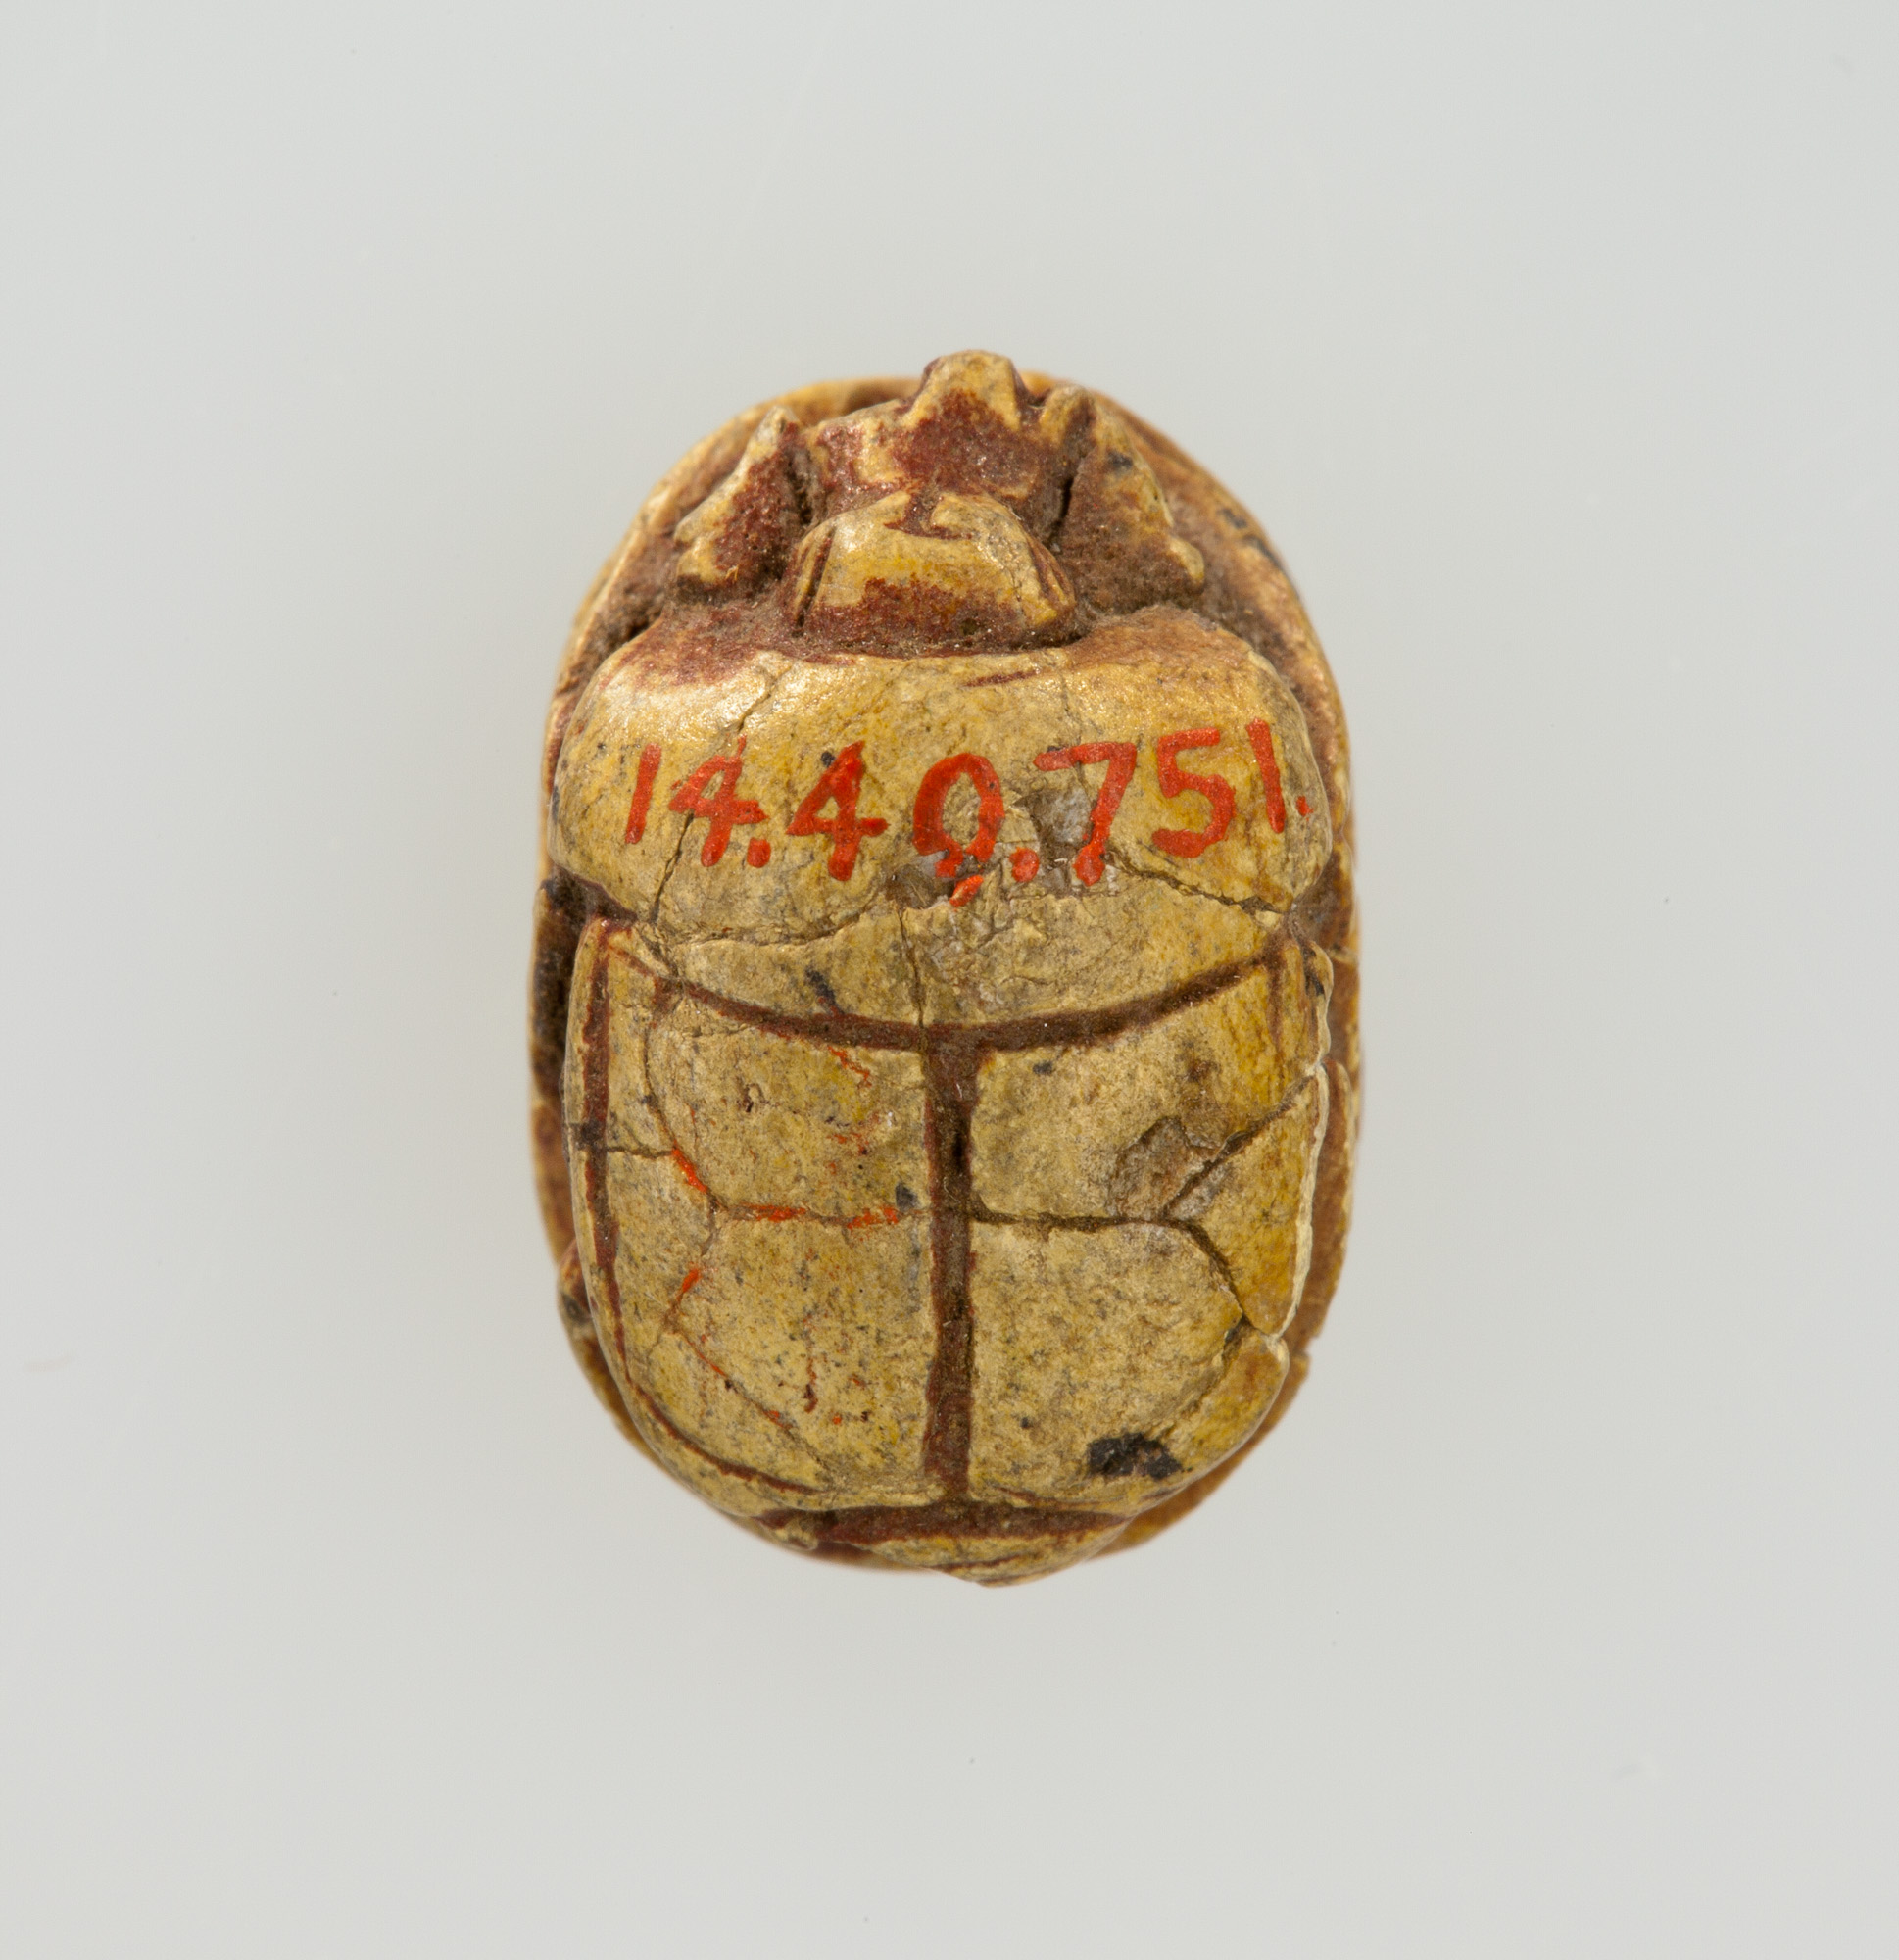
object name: scarab, wy. queen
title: Scarab Inscribed for an Unknown Queen Wy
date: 1550-1295 BCE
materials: stone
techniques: glazing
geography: egypt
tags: scarabs